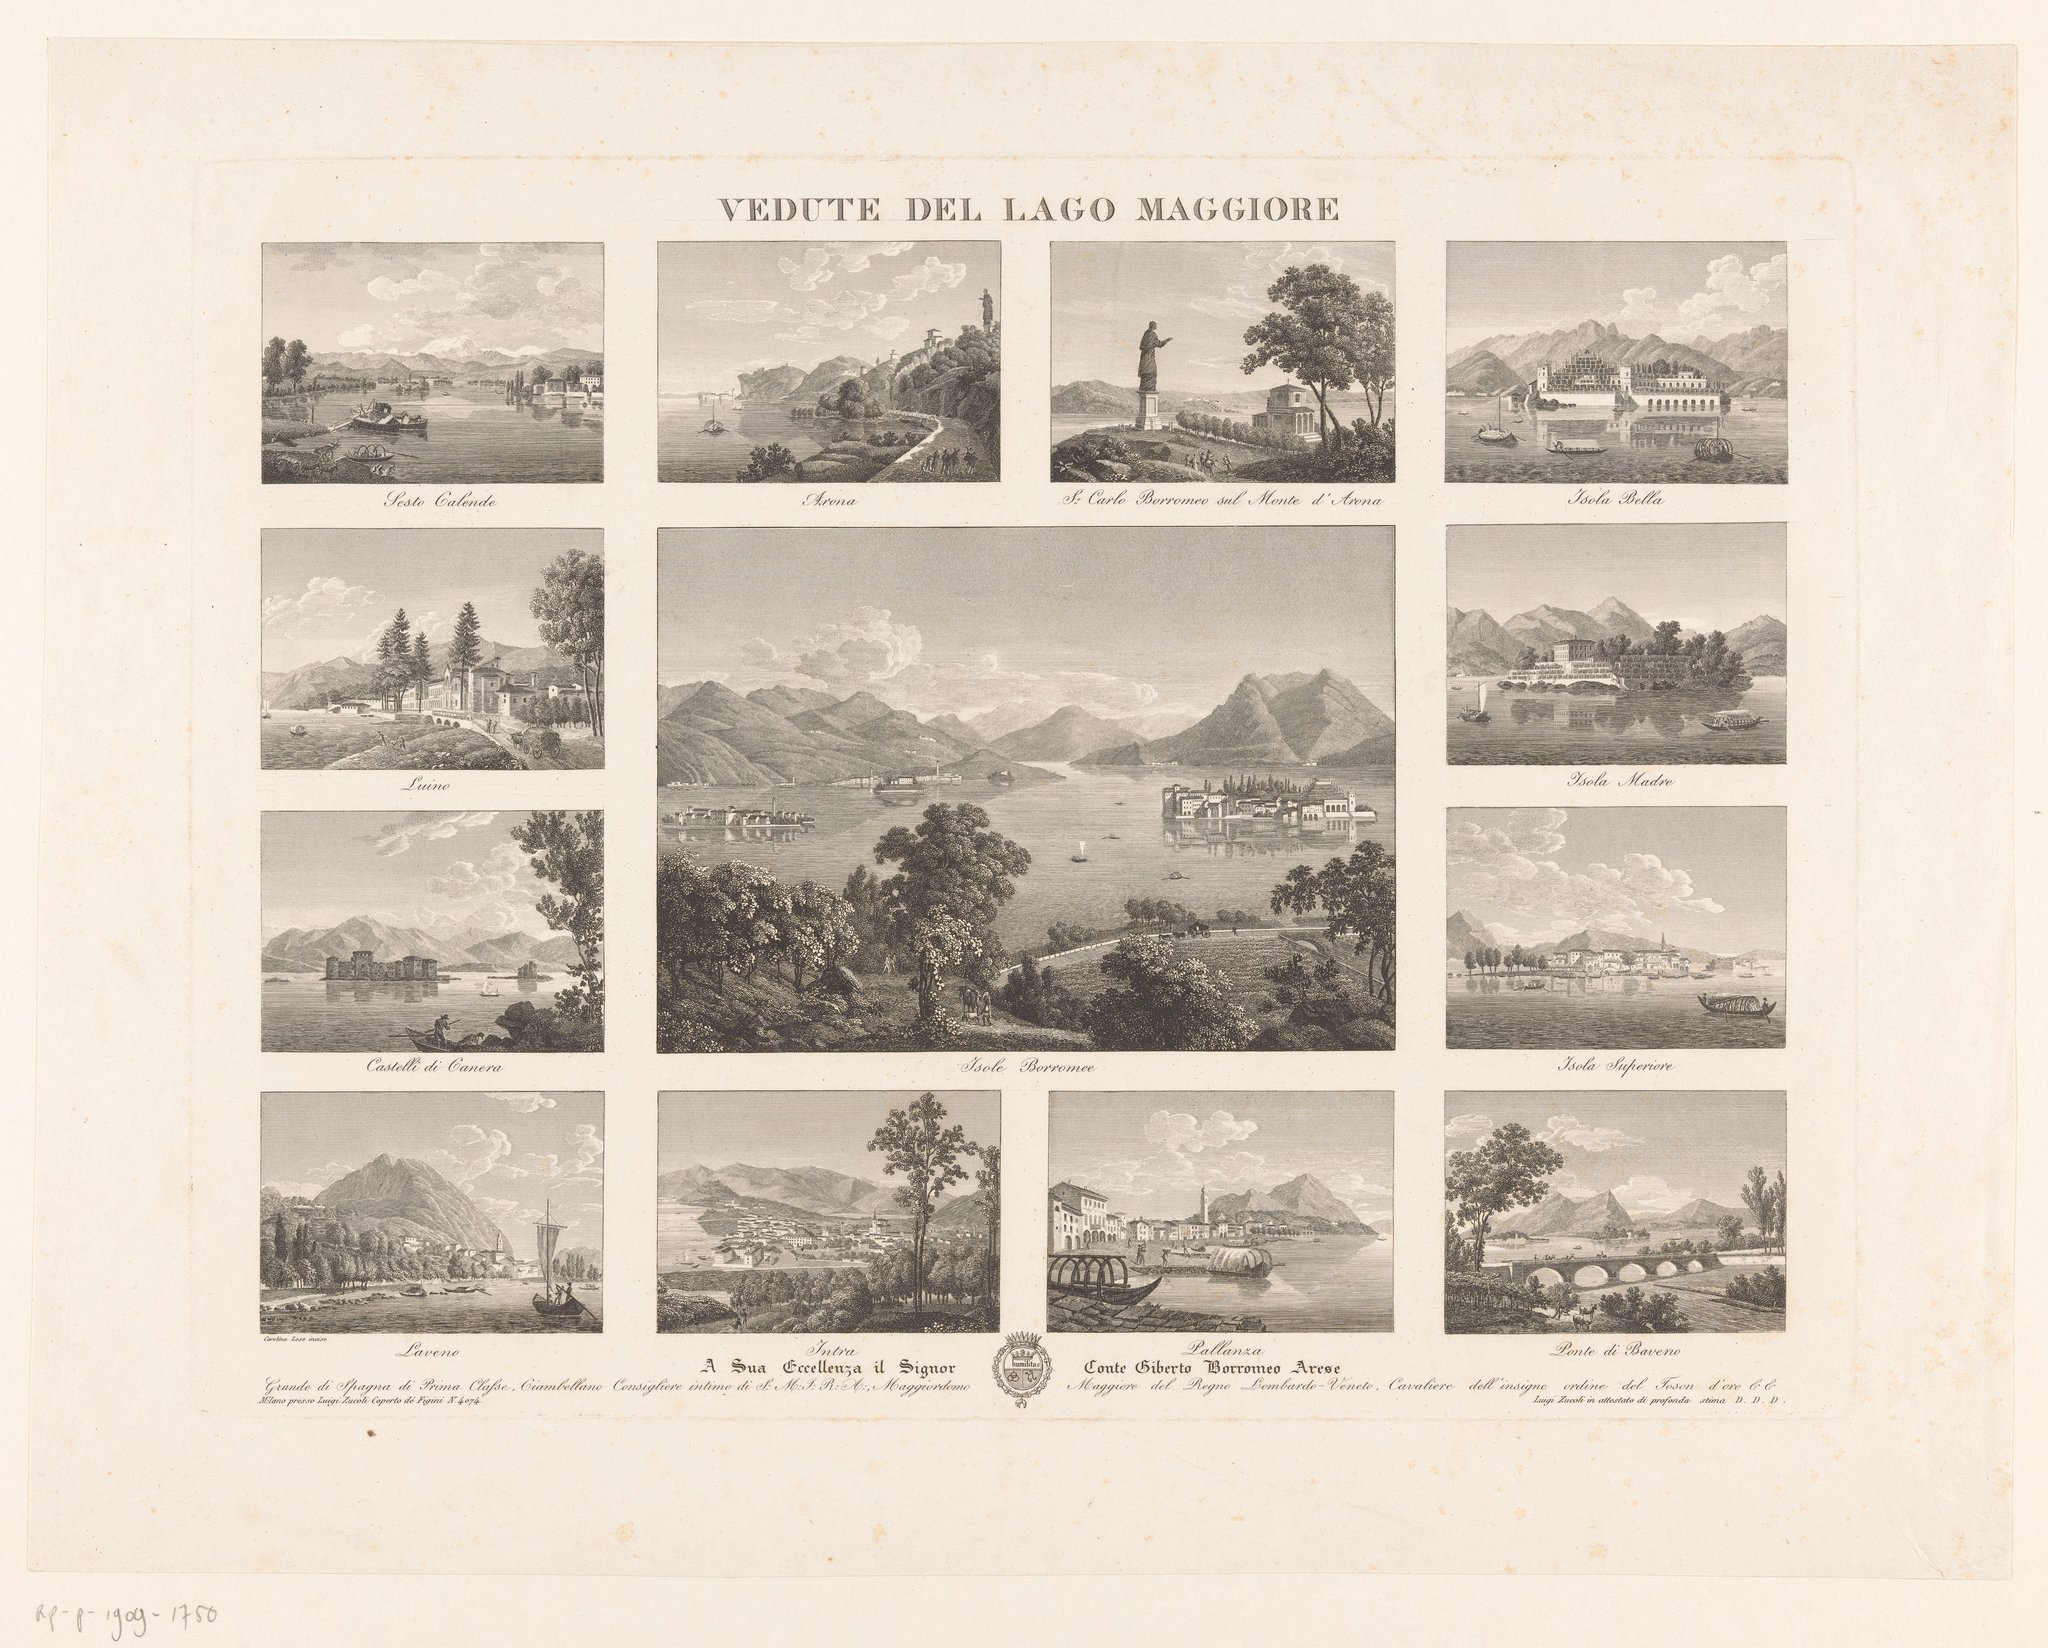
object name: print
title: Dertien gezichten op het Lago Maggiore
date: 1786-1850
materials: paper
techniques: engraving, etching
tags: city-view in general; 'veduta', armorial bearing, heraldry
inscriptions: collector's mark: Lugt 2228